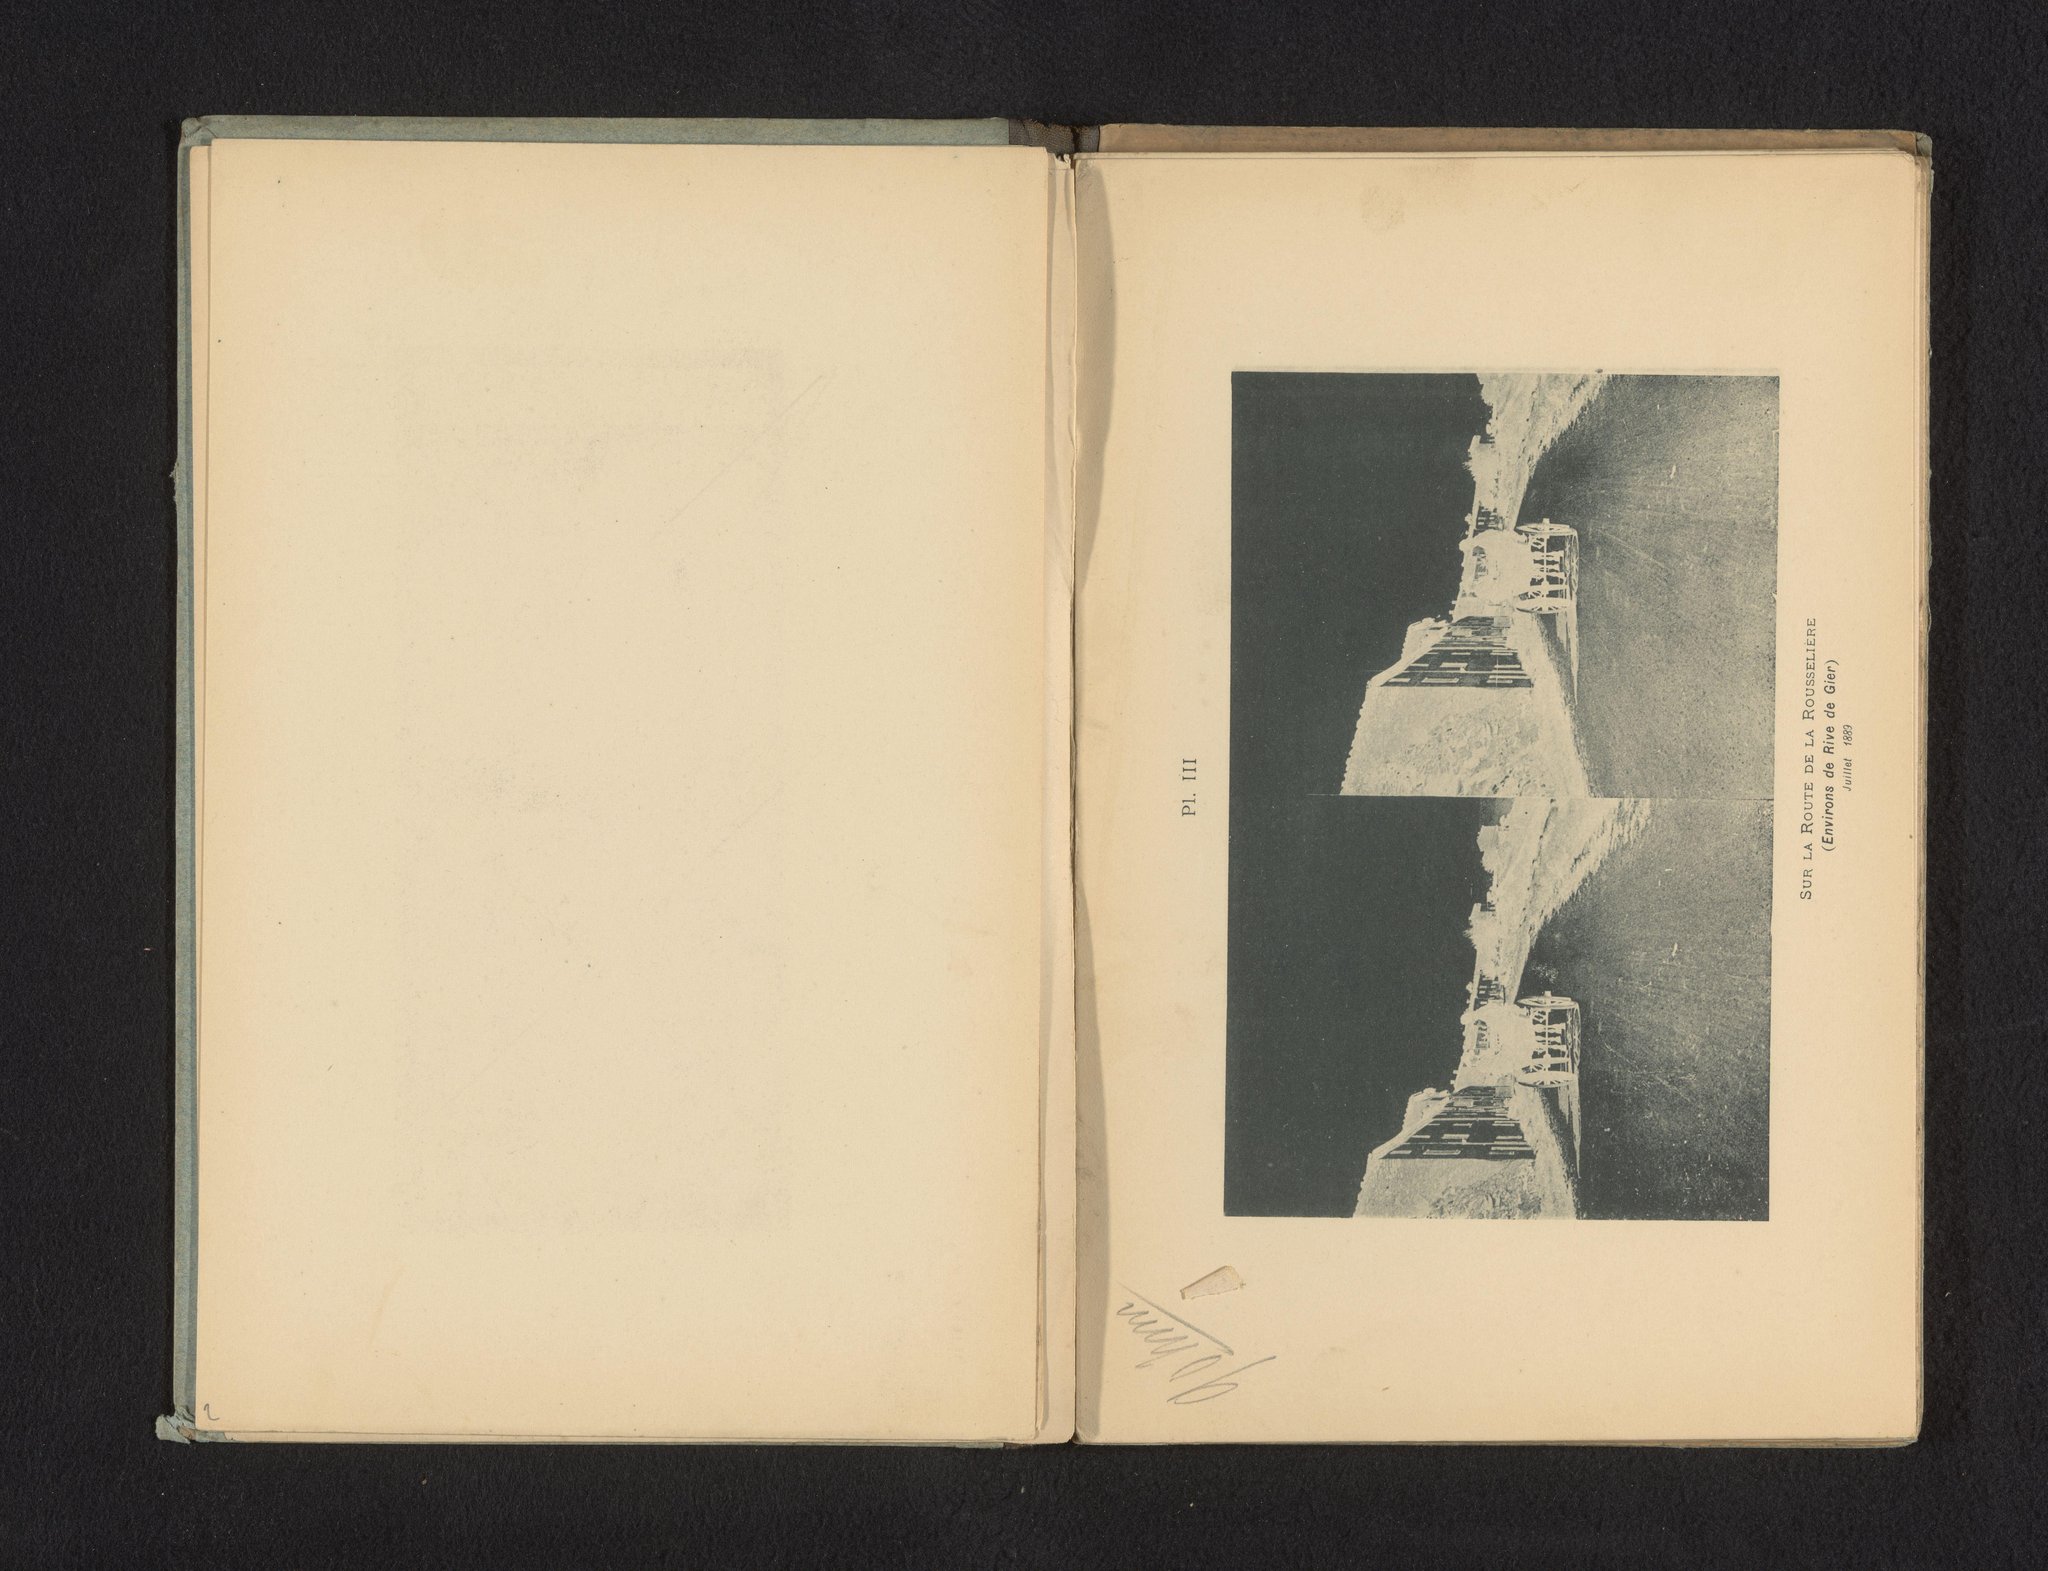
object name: stereograph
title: Stereofoto van een straatgezicht met paard en wagen in negatief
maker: adolphe louis donnadieu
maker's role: wetenschapper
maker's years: 1840-1911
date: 1882-1892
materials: paper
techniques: photograph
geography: rive-de-gier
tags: passenger carriage, street (+ city(-scape) with figures, staffage)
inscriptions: inscription: ‘Pl. III’, inscription: ‘Juillet 1889’, annotation: ‘90 mm’